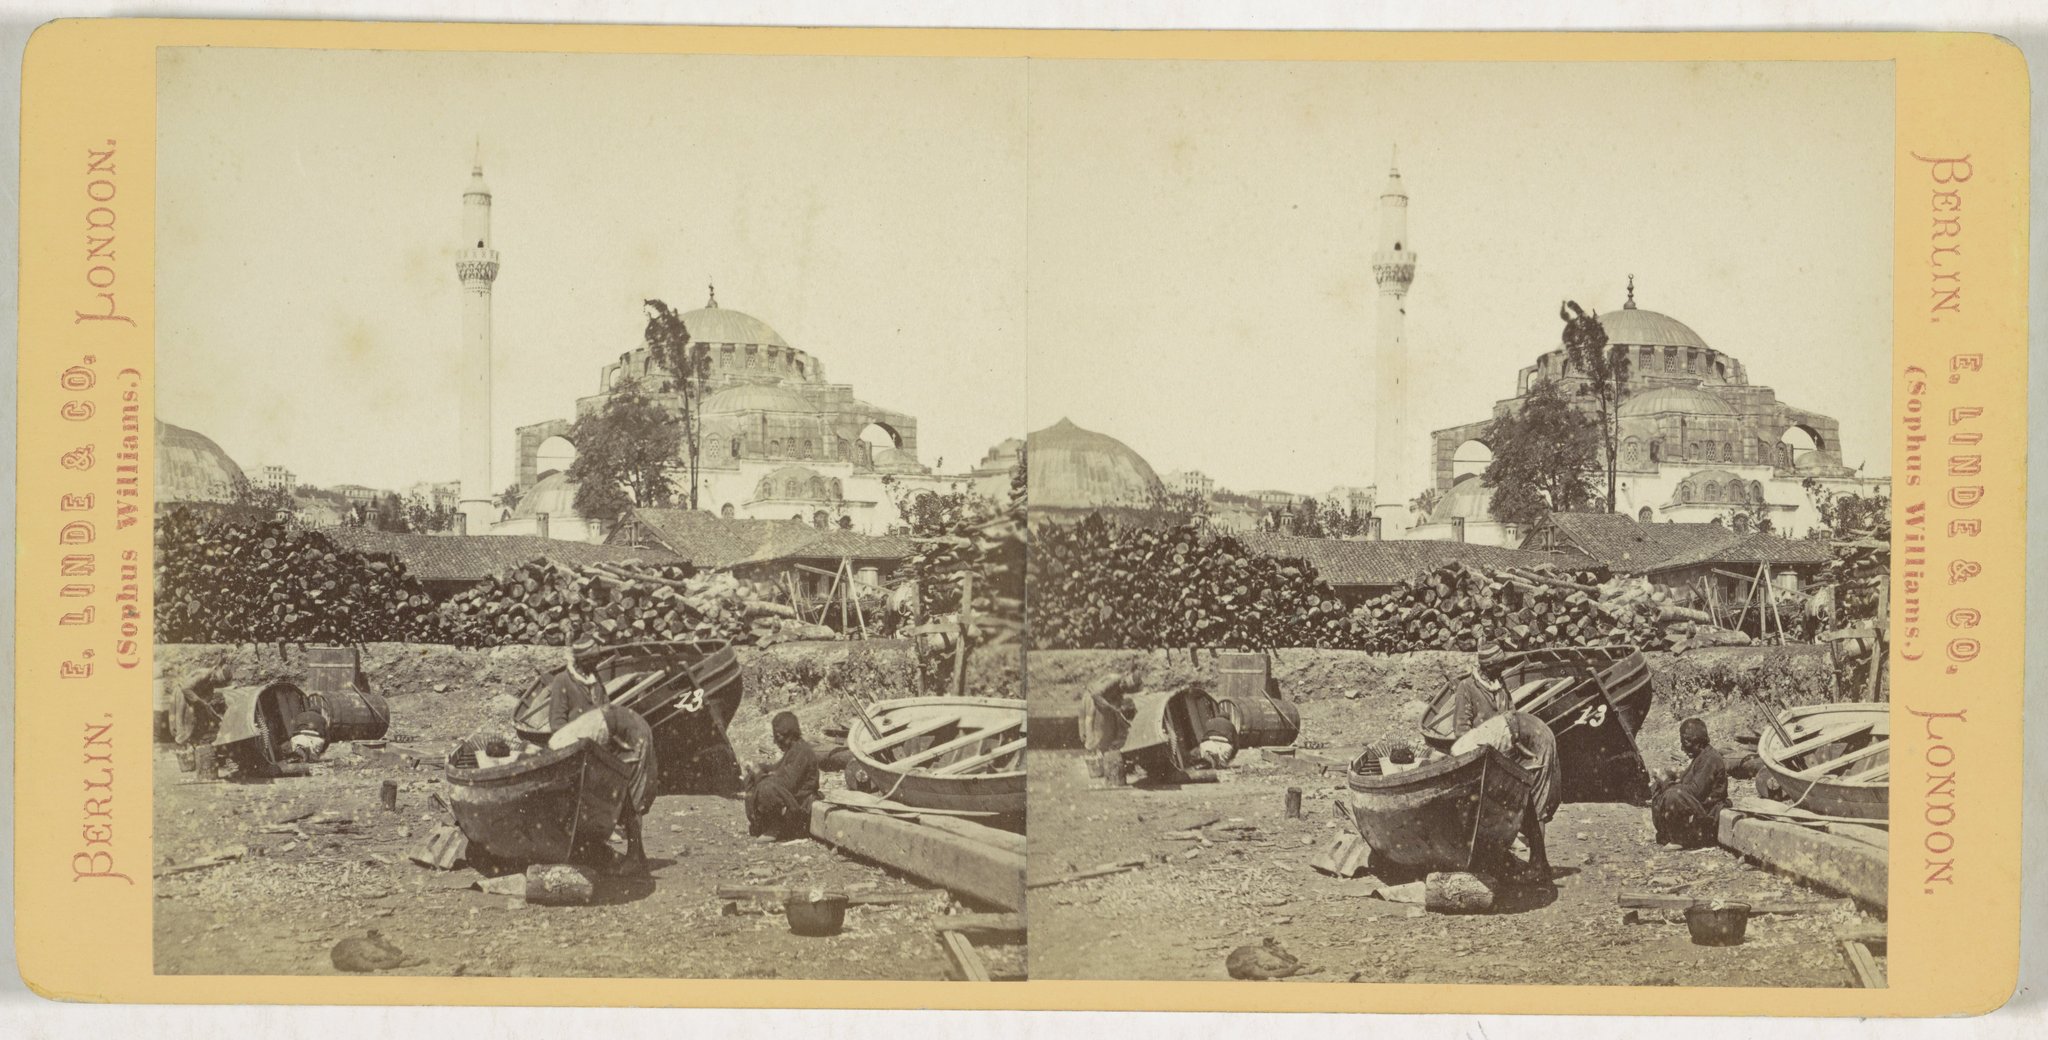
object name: stereograph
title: Boten aan de oever nabij de Kiliç Ali Pasha moskee, Istanboel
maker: Anonymous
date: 1873-1890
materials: cardboard, paper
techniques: albumen print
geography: kiliç ali pasha complex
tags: temple, shrine ~ islam, mohammedanism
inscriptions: number: ‘13’